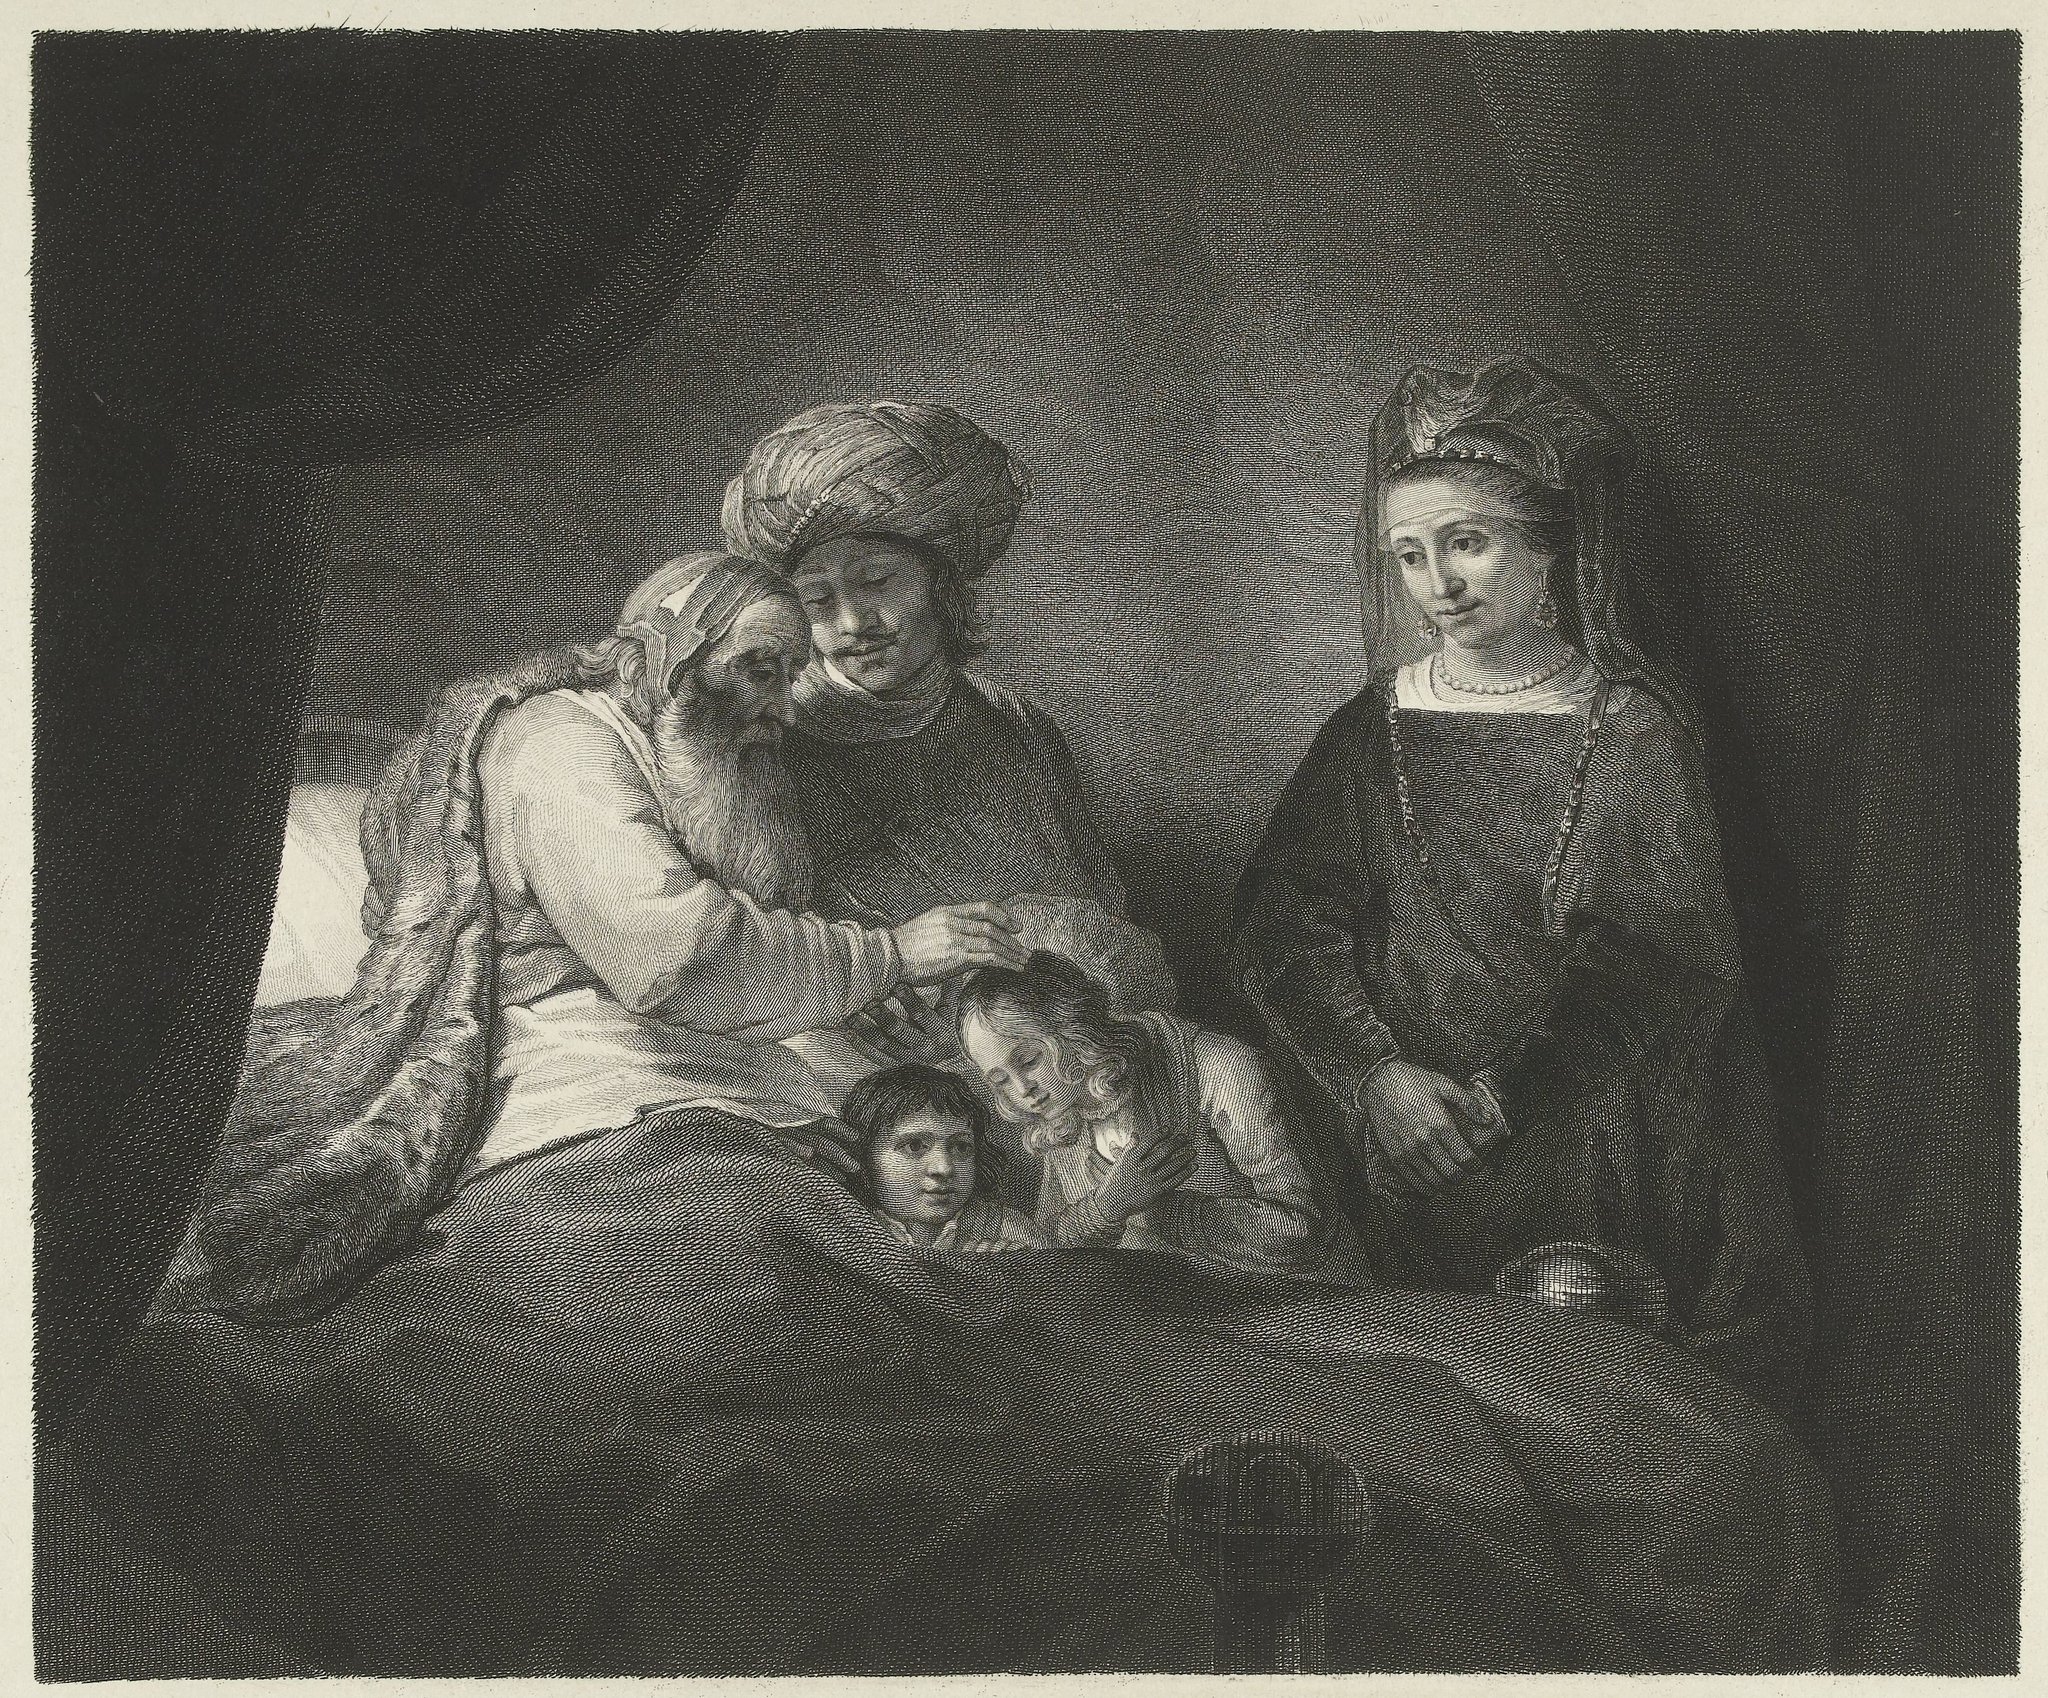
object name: print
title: Jakob zegent Efraïm en Manasse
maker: lambertus antonius claessens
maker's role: draughtsman, print maker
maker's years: 1763-1834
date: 1808-1834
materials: paper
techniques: engraving, etching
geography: paris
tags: jacob blesses manasseh and ephraim with arms crossed; joseph may be shown trying to uncross them or expressing (with asenath) his disapproval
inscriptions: collector's mark: Lugt 2228, collector's mark: Stempel van het Musee Napoleon, voorloper van het Louvre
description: Vlak voor zijn dood zegent Jakob de zonen van zijn zoon Josef, Efraïm en Manasse. Jacob kruist zijn handen bij de zegening en zegent met zijn rechterhand Efraïm en met zijn linkerhand Manasse. Jozef probeert Jakobs armen te verleggen maar het lukt hem niet.